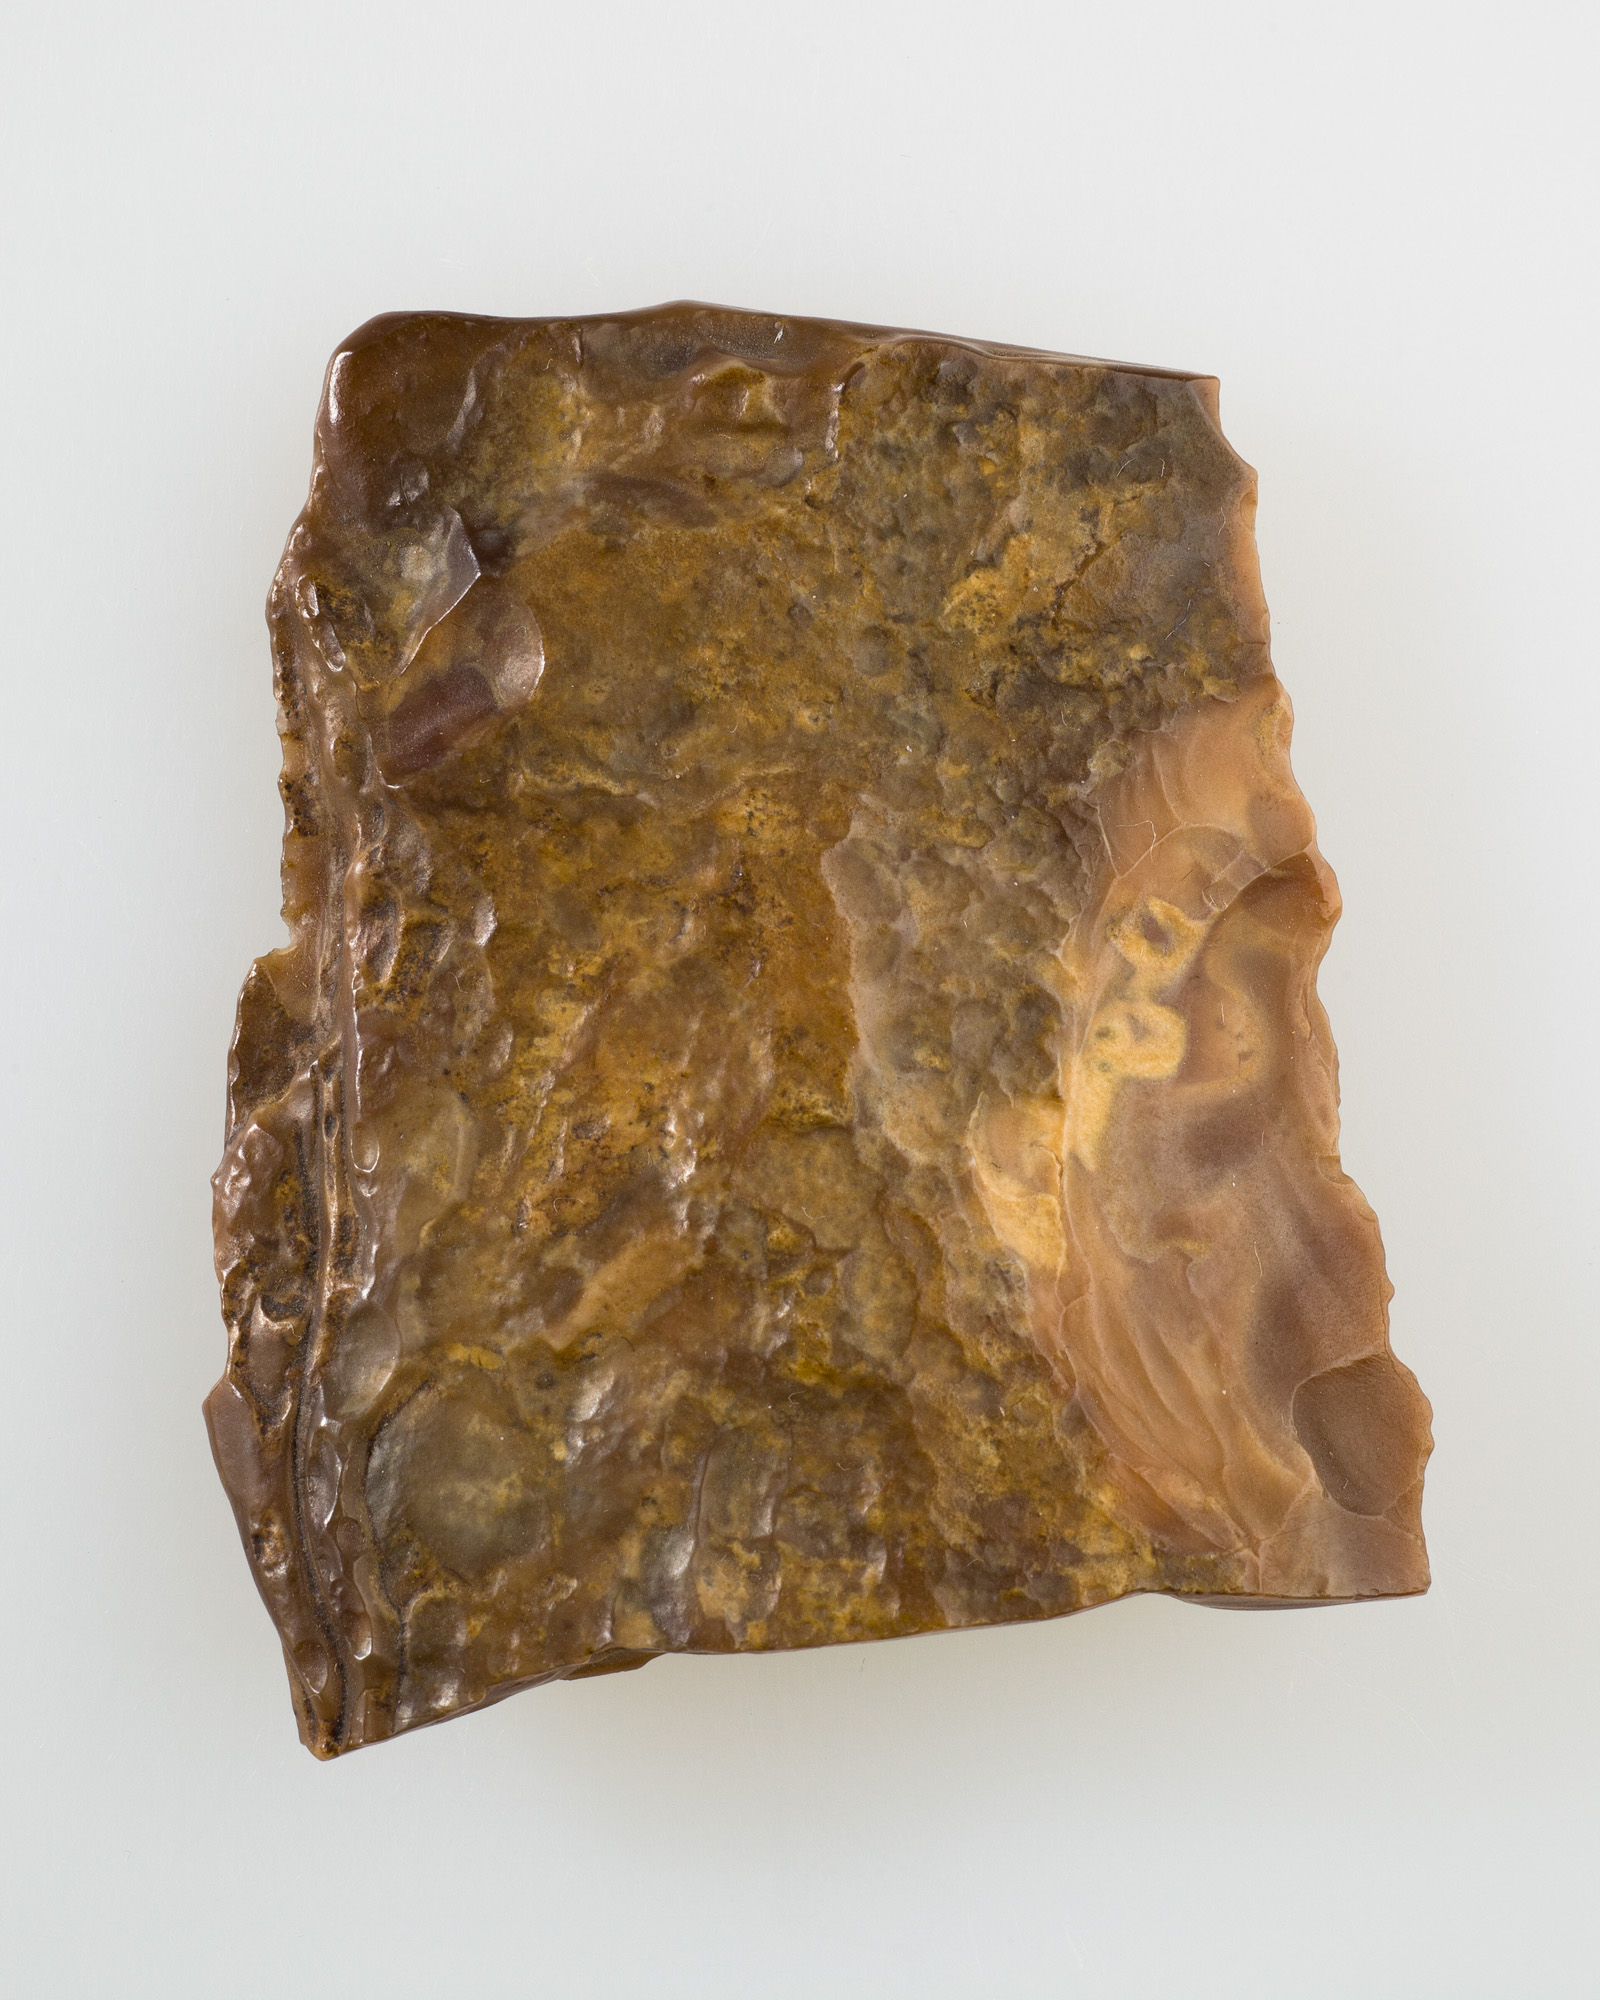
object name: tool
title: Tool Fragment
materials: stone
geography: egypt